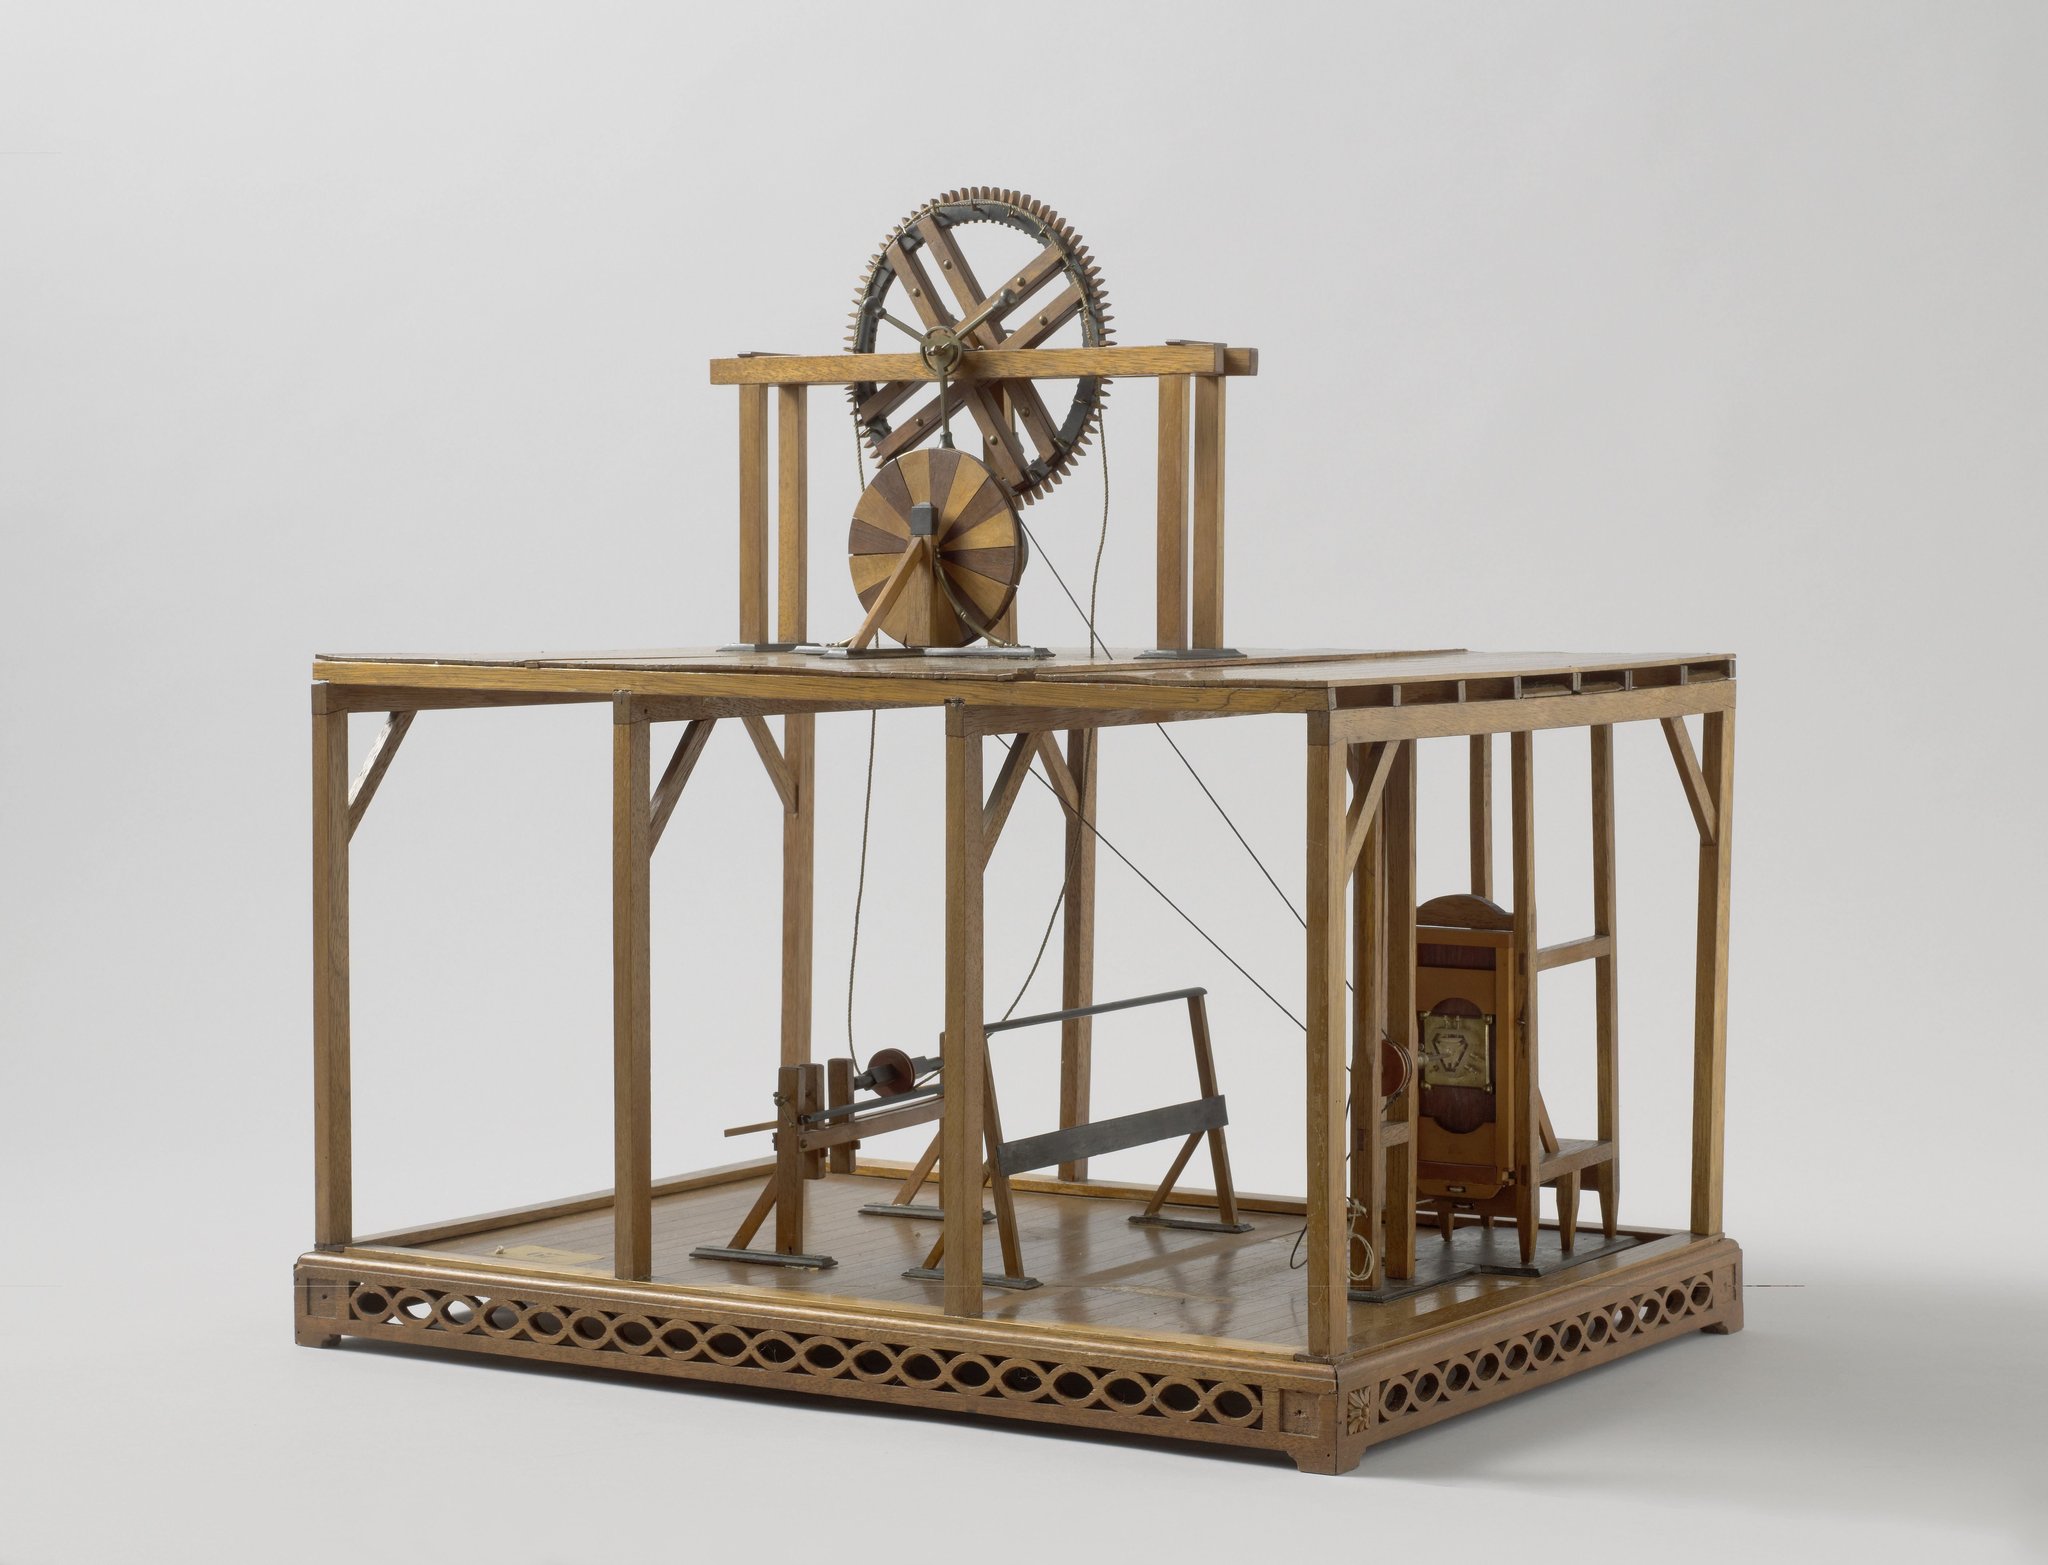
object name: demonstration model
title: Model of a Lathe and Drilling Machine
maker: Anonymous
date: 1797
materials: brass, iron, lead, fiber, wood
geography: amsterdam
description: Obreen beschrijft dit model als een werkplaats voor het boren van gaten in de wielen van affuiten en voor het draaien van de tappen der assen. Asmus beschreef het slechts als een draaibank van eigen uitvinding, die zowel in Vlissingen als te Amsterdam op de Landswerf werd uitgevoerd.